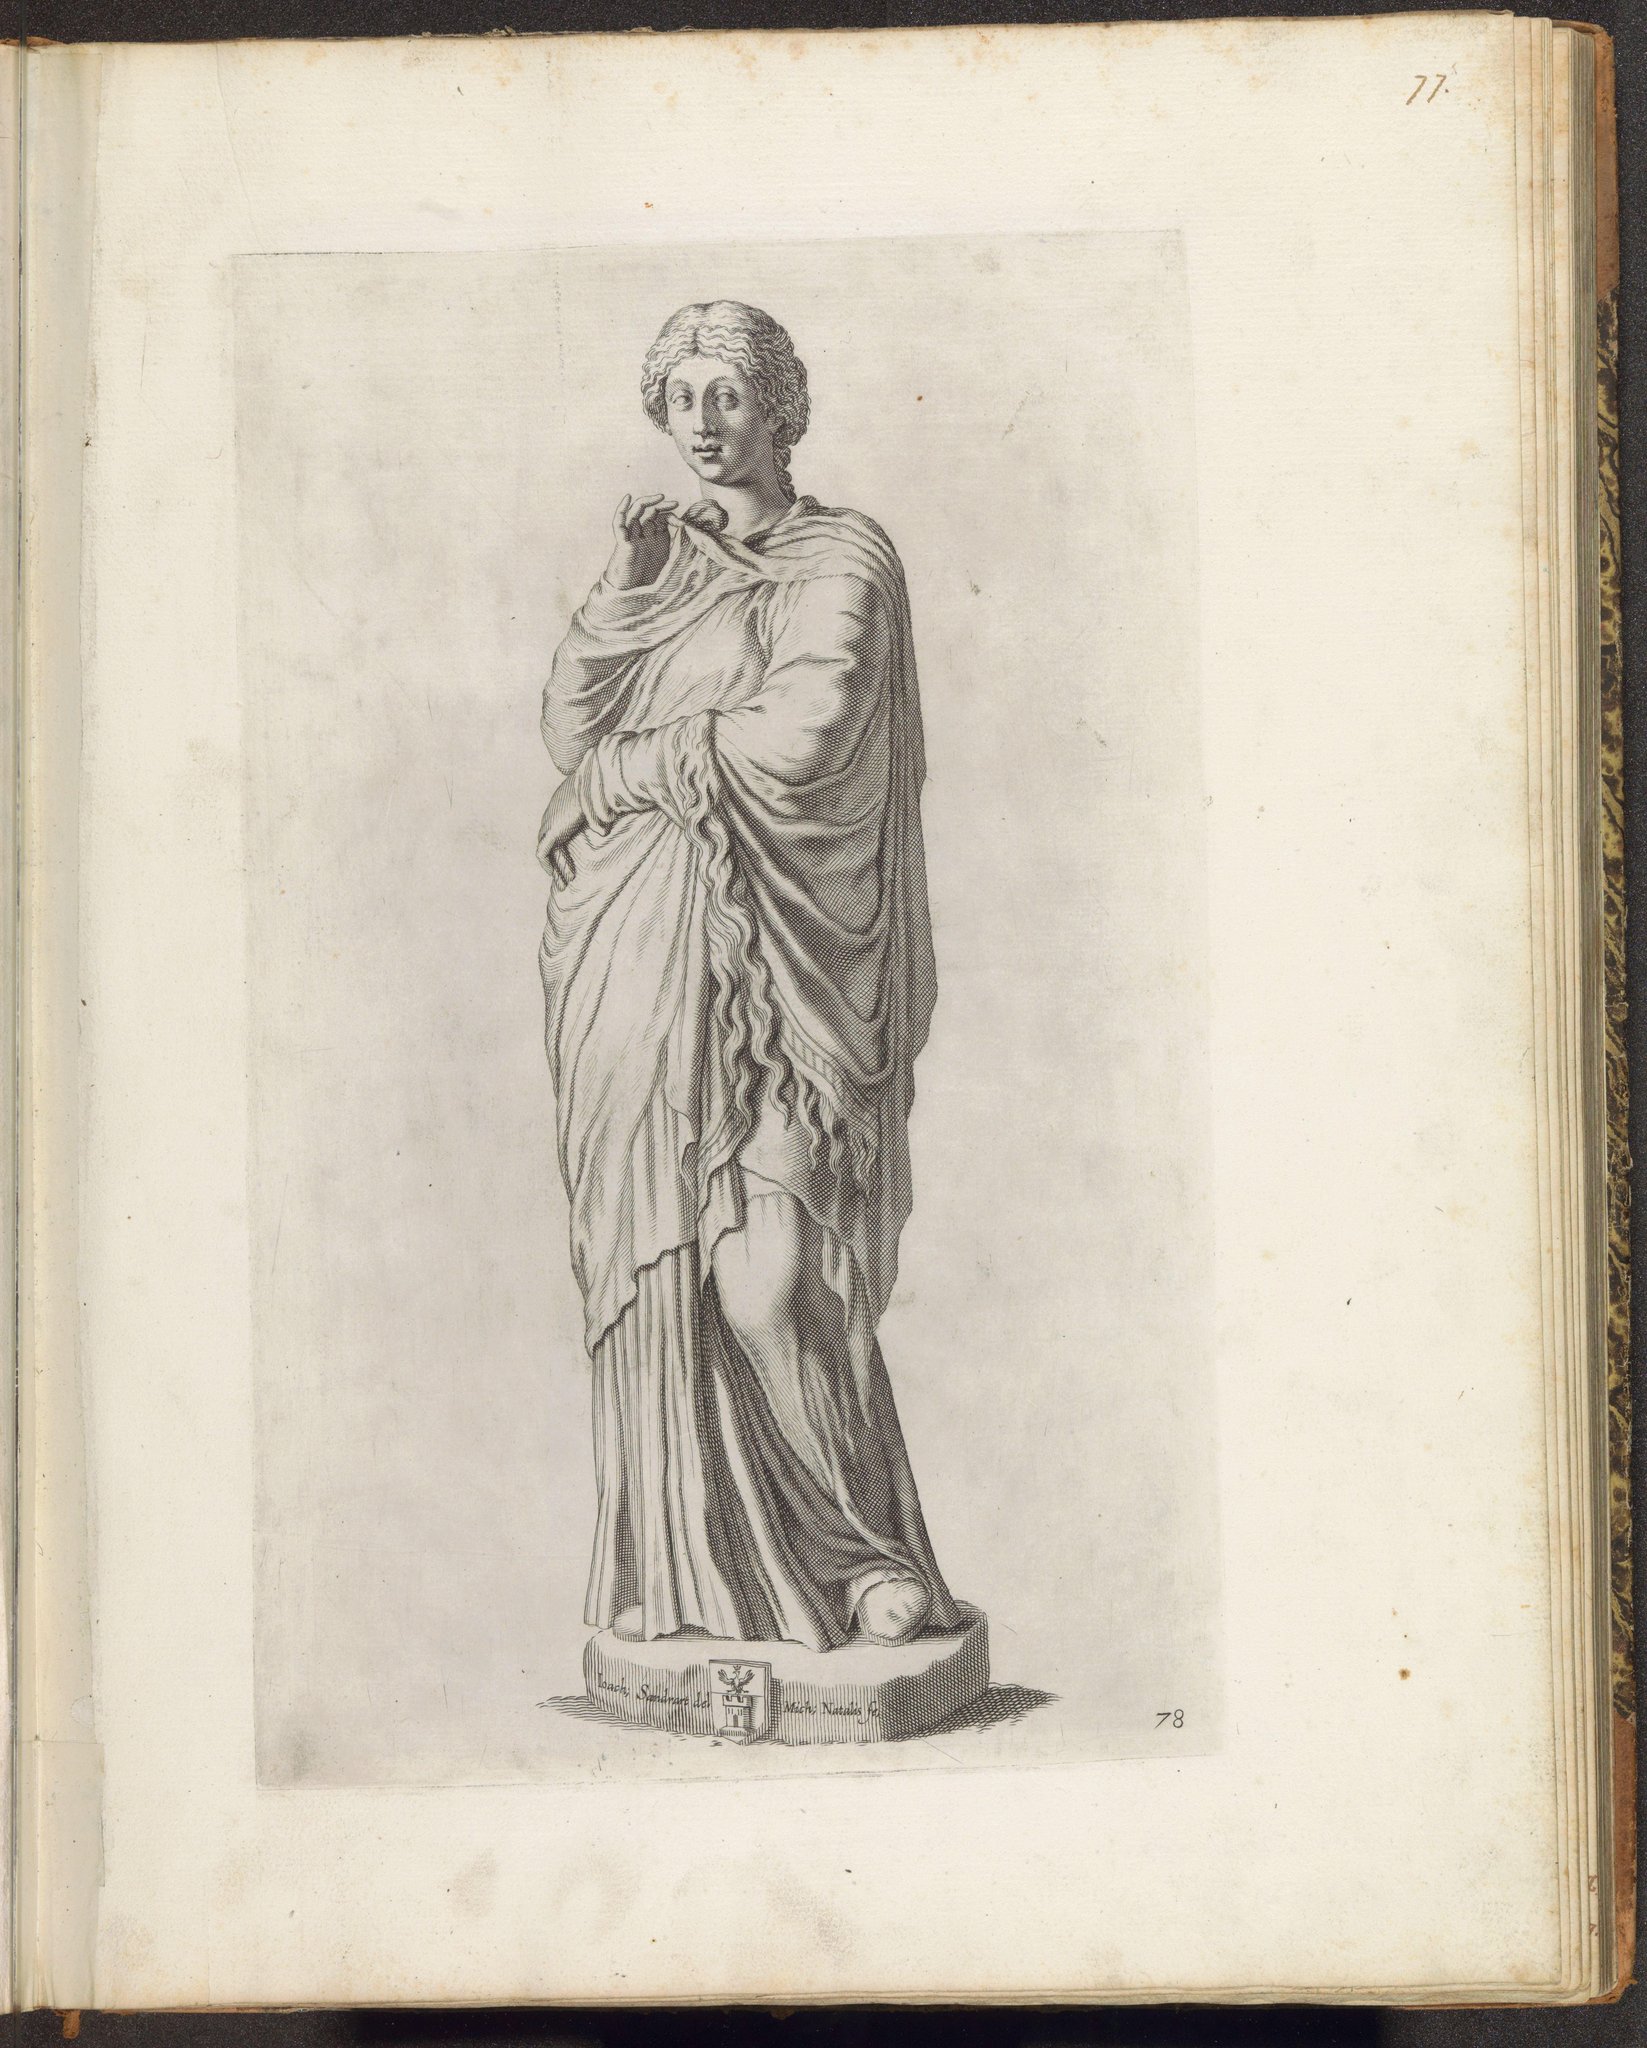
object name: album leaf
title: Standbeeld van een vrouw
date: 1636-1647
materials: paper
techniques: engraving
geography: rome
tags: adult woman, piece of sculpture, reproduction of a piece of sculpture, classical history (+ full length)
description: Standbeeld van een vrouw gekleed in een lang klassiek gewaad. Haar linkerarm houdt zij voor haar lichaam, met haar rechterhand houdt zij haar kleed op haar borst vast. Haar haren draagt zij in een vlecht. Op de basis het wapenschild van Vincenzo Giustiniani. Prent maakt deel uit van een album met een serie prenten naar de sculpturen in de verzameling in de Galleria Giustiniani te Rome.